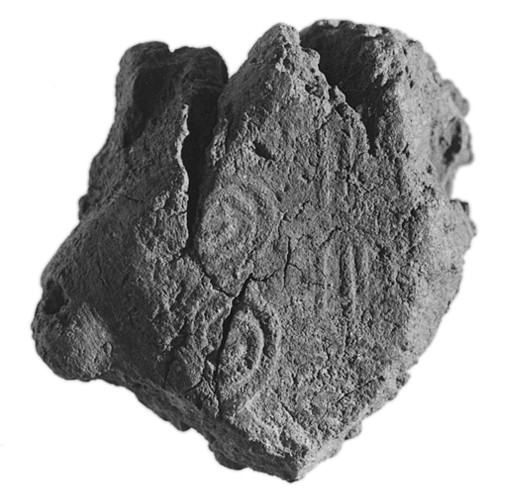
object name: sealing fragment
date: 2030-1640 BCE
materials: clay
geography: egypt